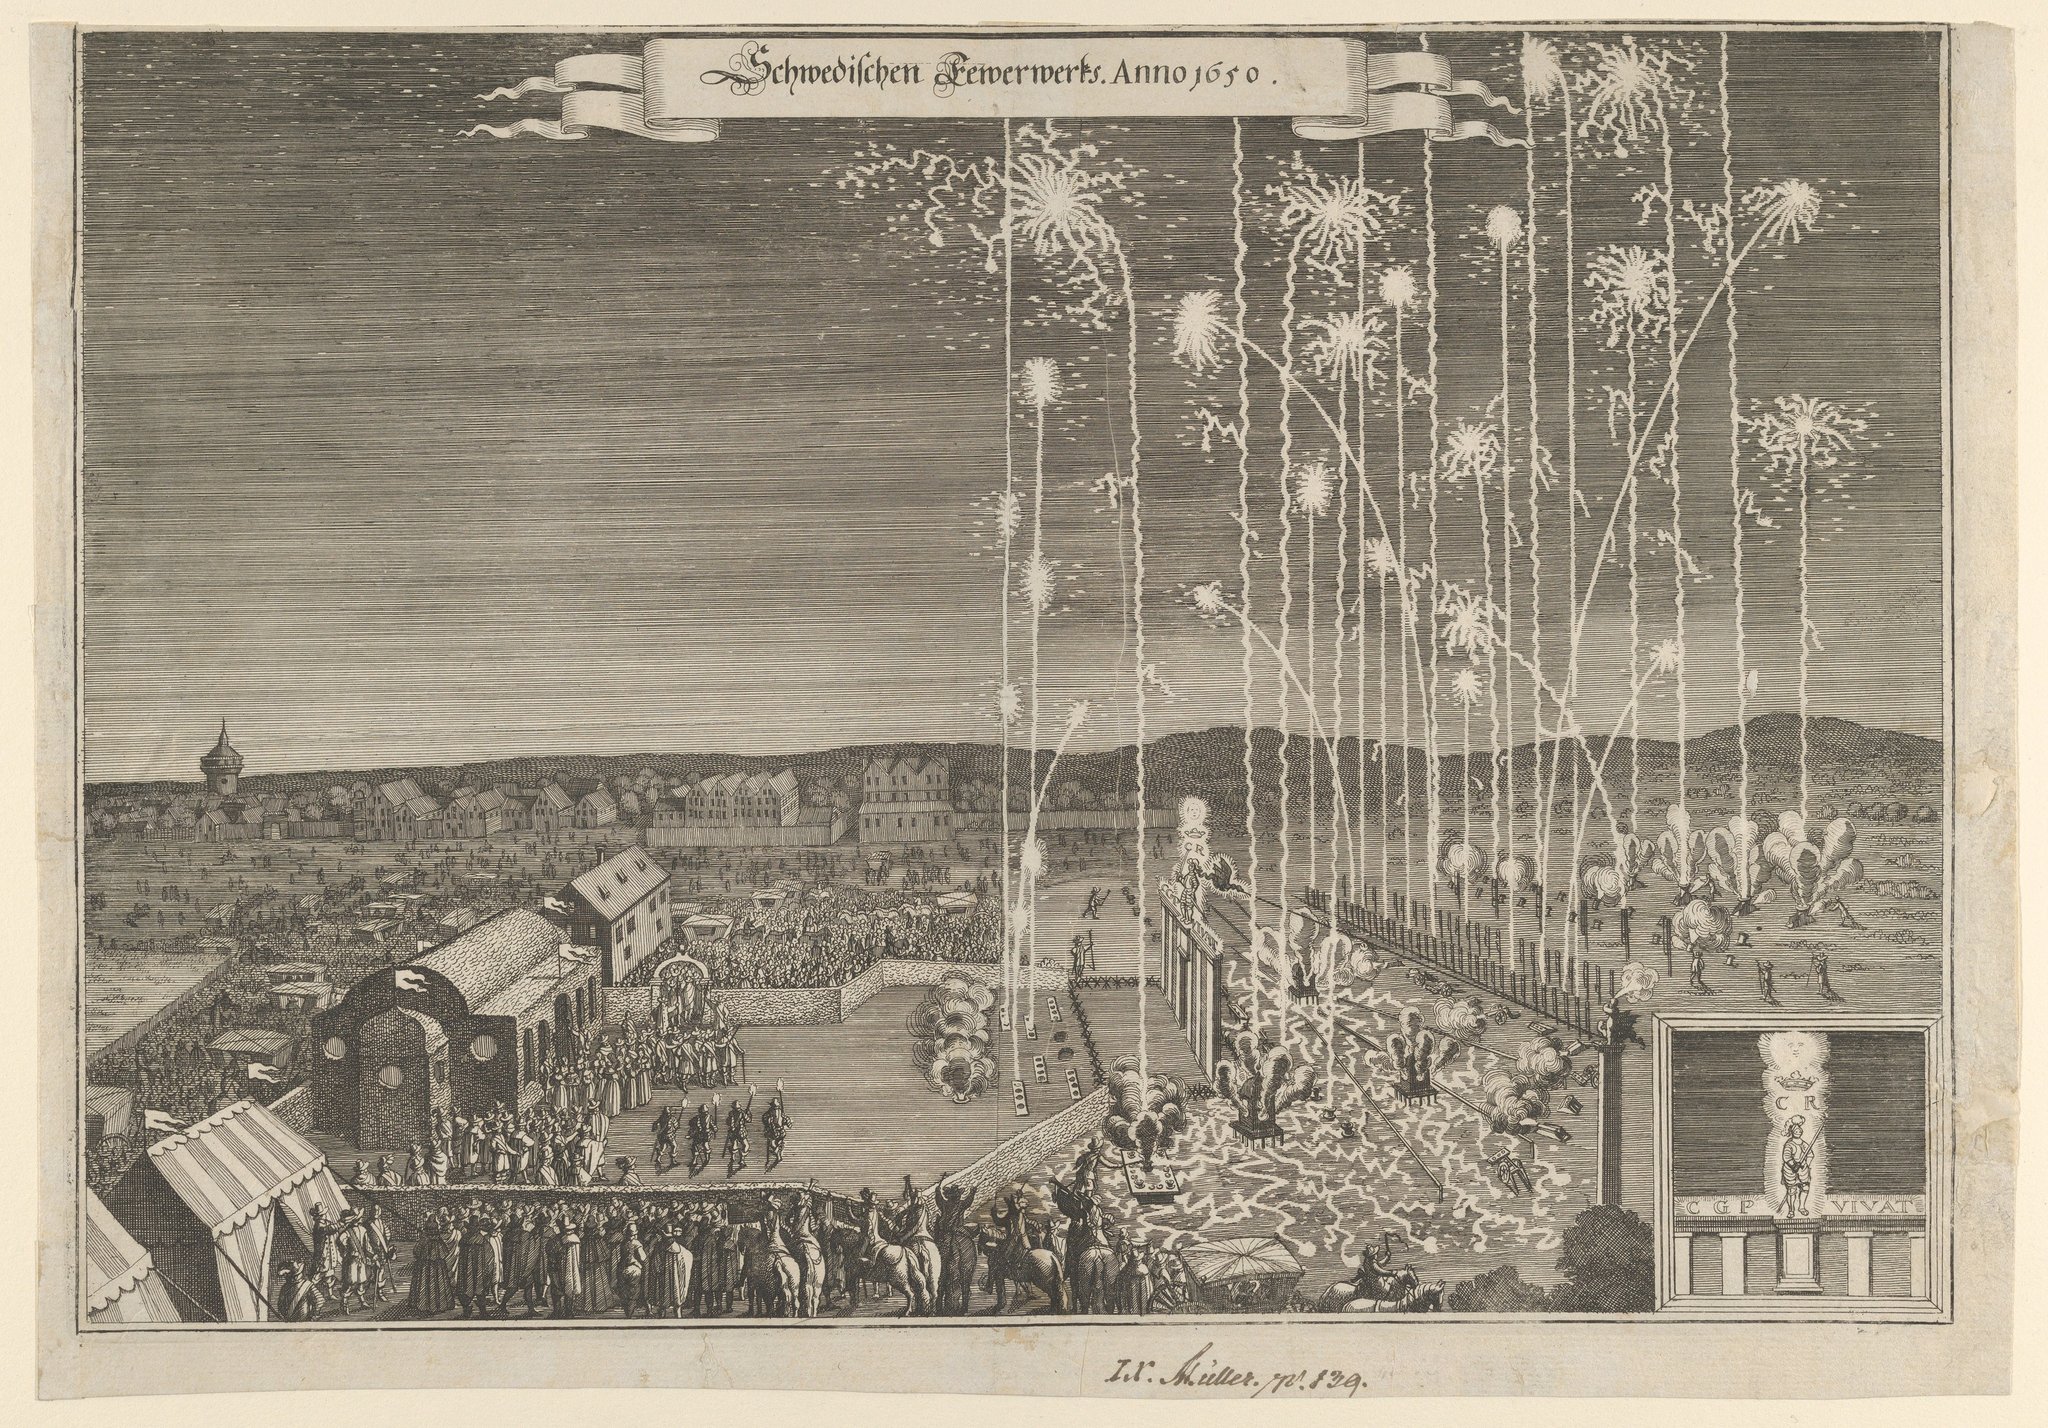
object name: print, fete, ornament architecture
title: Fireworks given by the Swedish ambassadors to honor Karl Gustav, Count Palatine, executed by Johann Carl, Nuremberg 1650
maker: Anonymous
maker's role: artist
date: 1650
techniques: etching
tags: fireworks